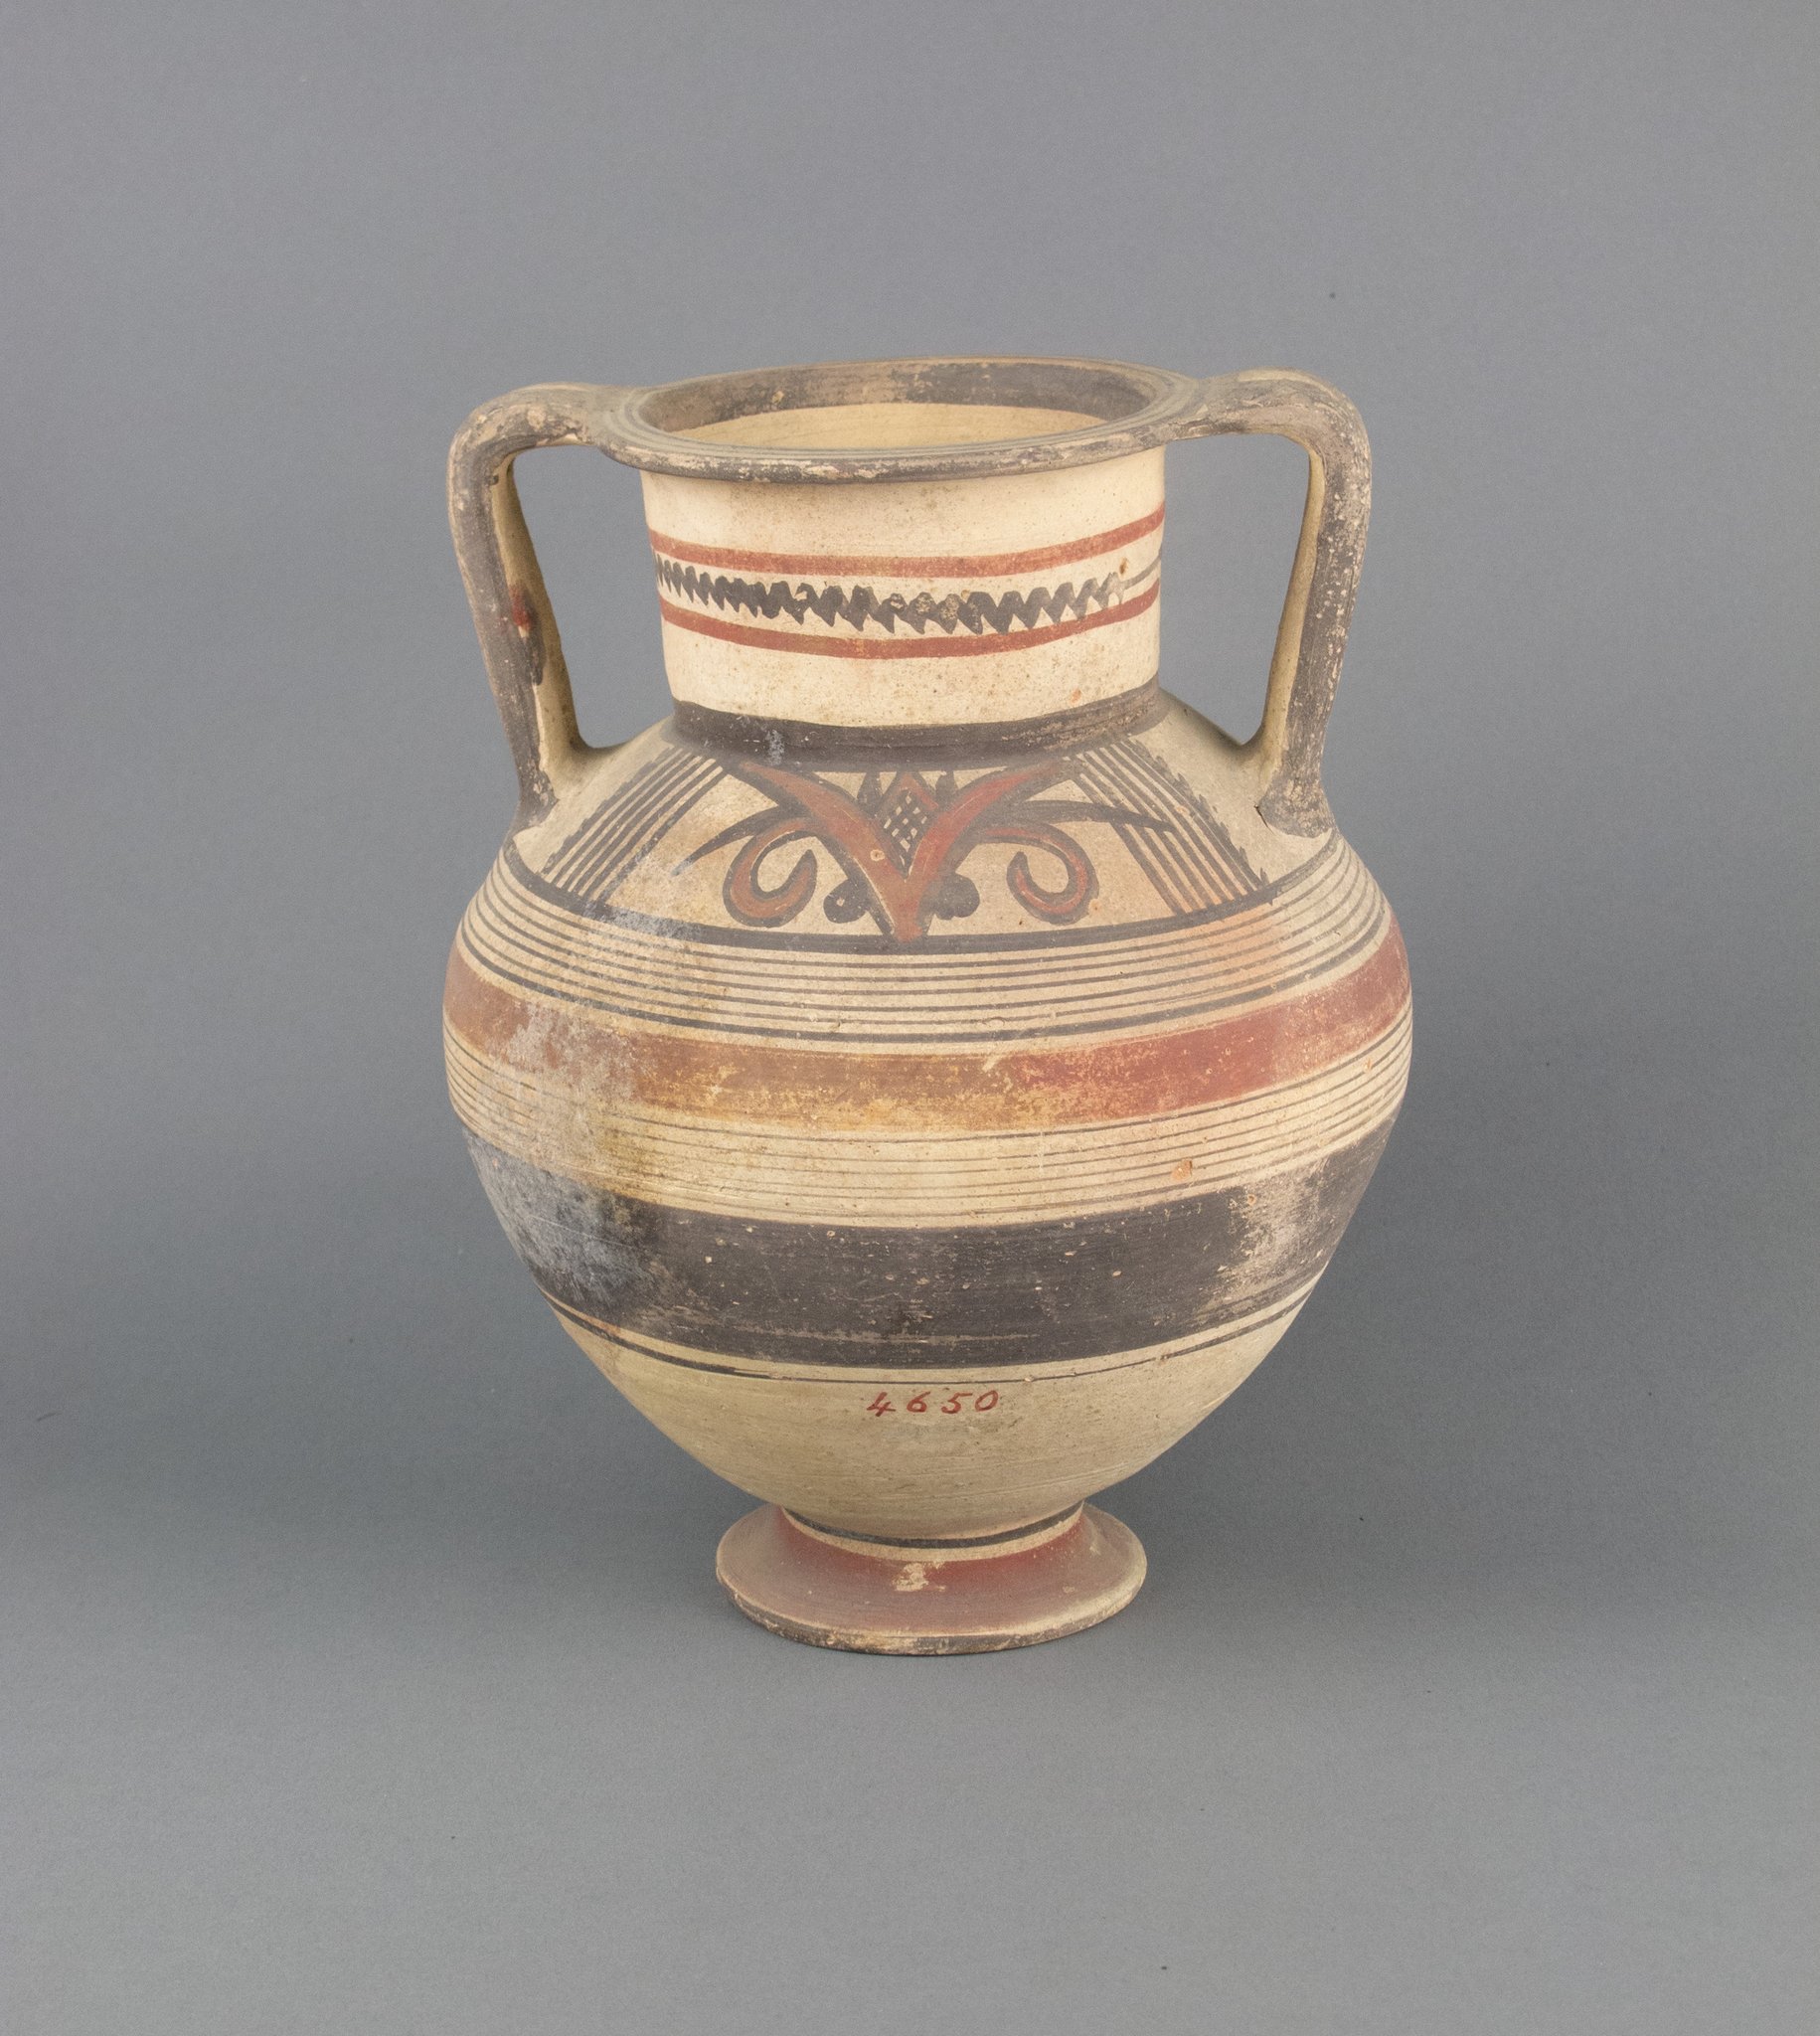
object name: krater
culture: cypriot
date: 750-600 BCE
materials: terracotta